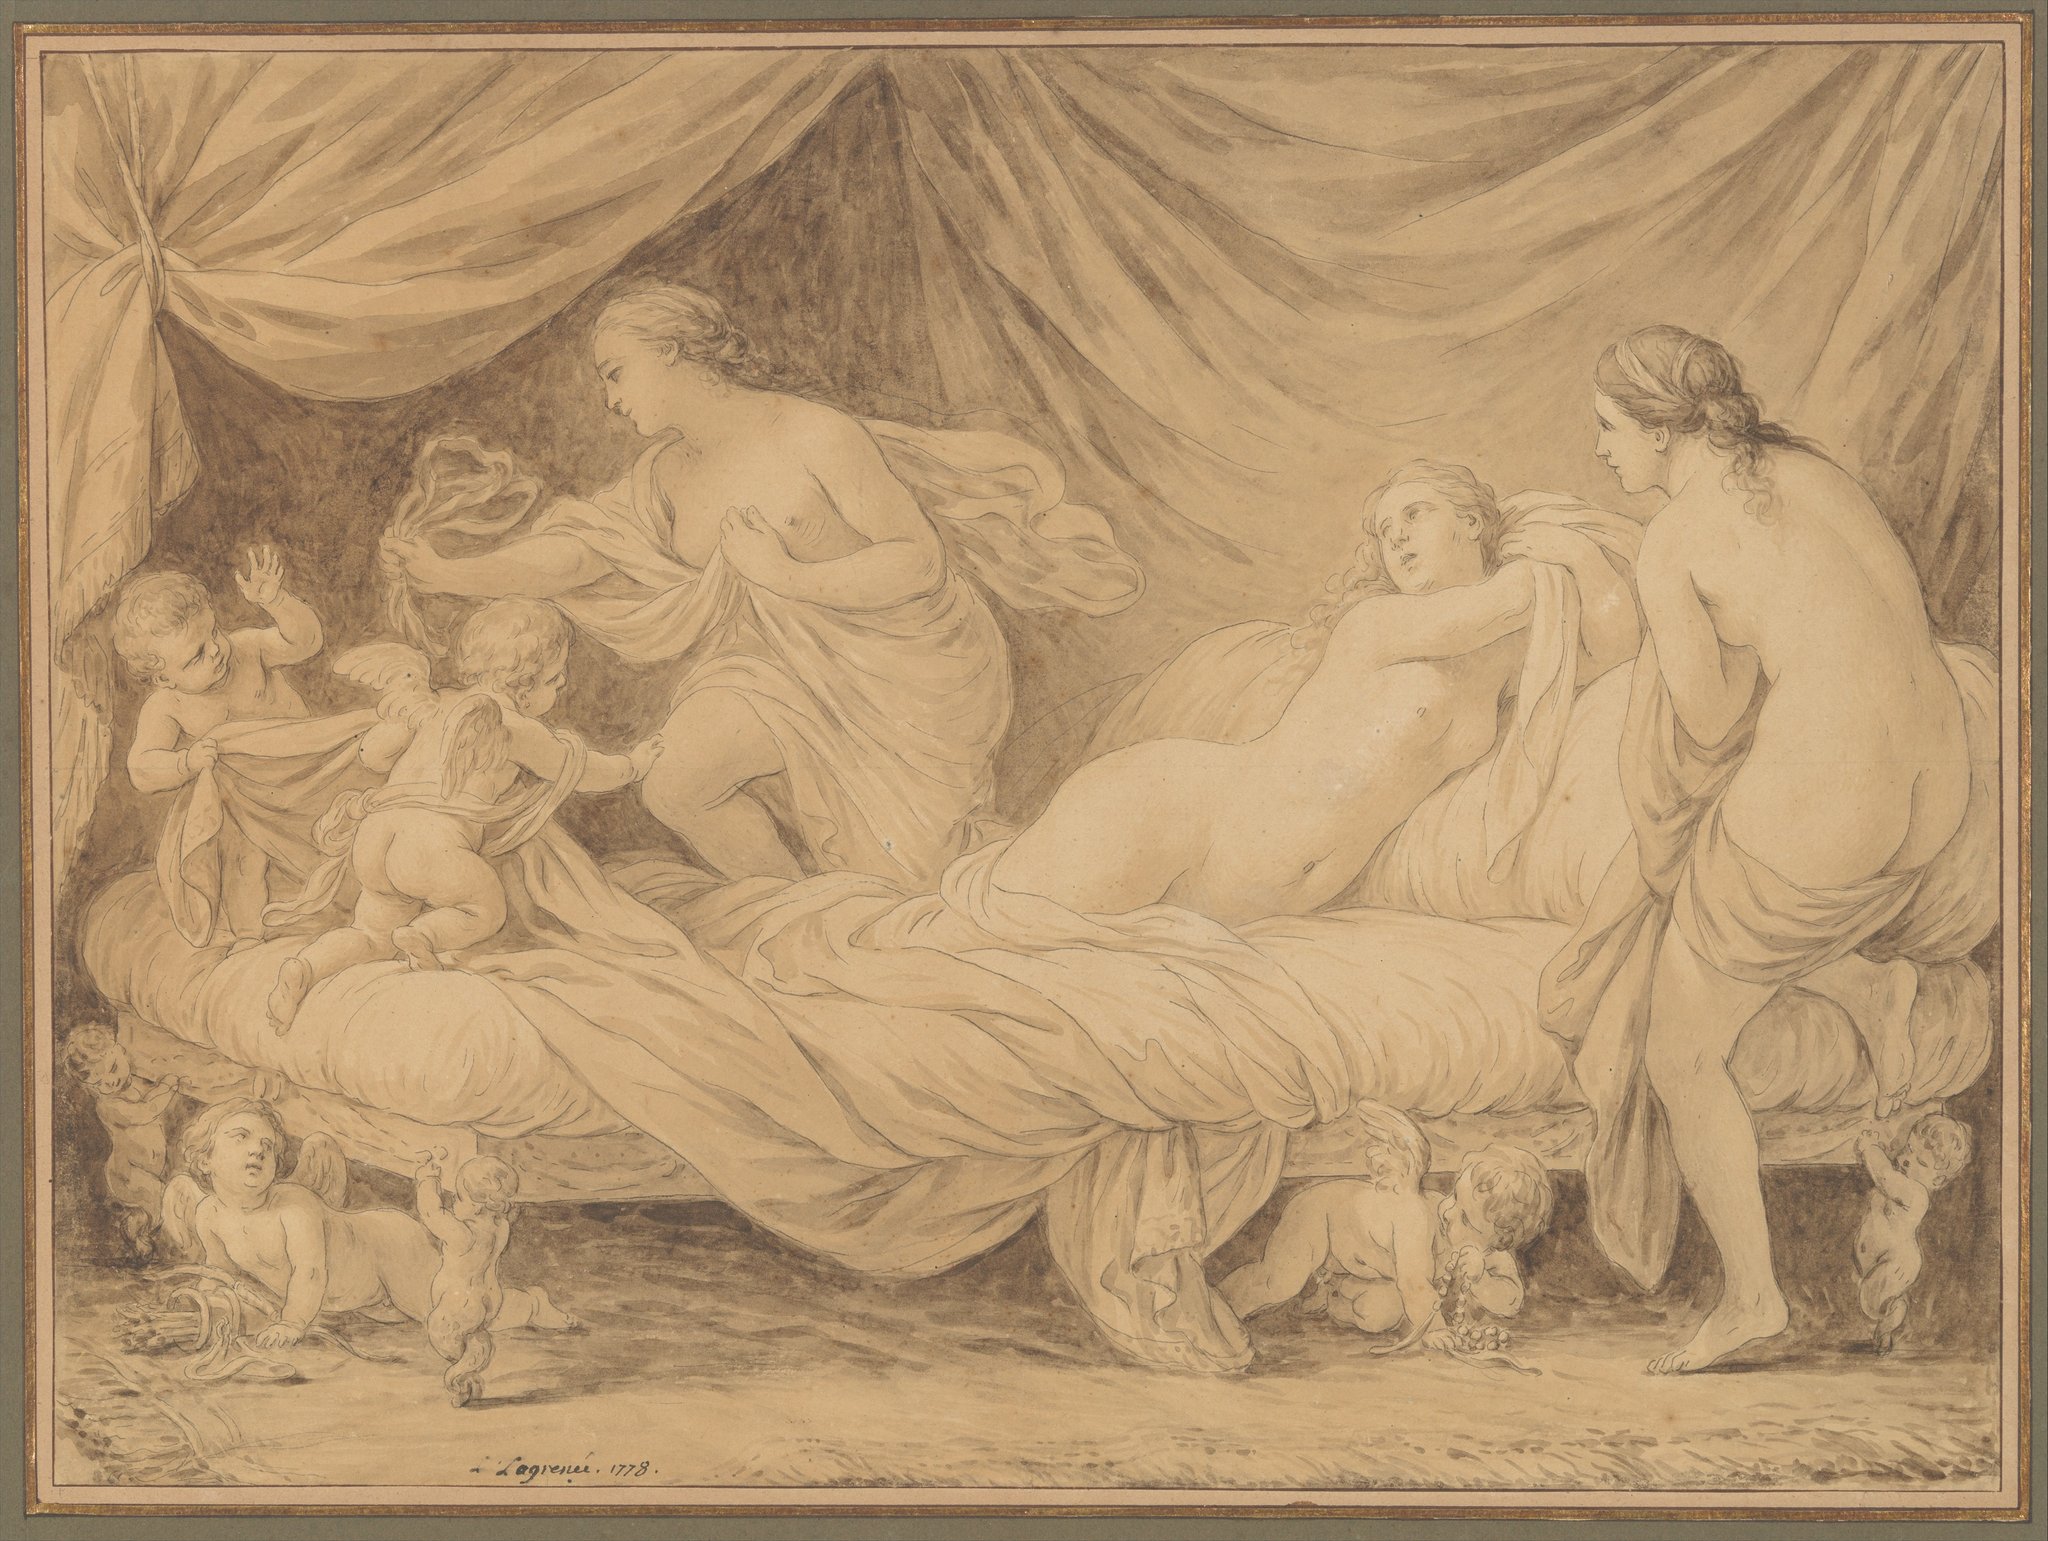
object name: drawing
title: Les Grâces lutinées par les amours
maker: louis lagrenée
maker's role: artist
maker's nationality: french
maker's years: 1725-1805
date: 1778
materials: chalk, ink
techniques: brush, pen, wash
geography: france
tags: female nudes